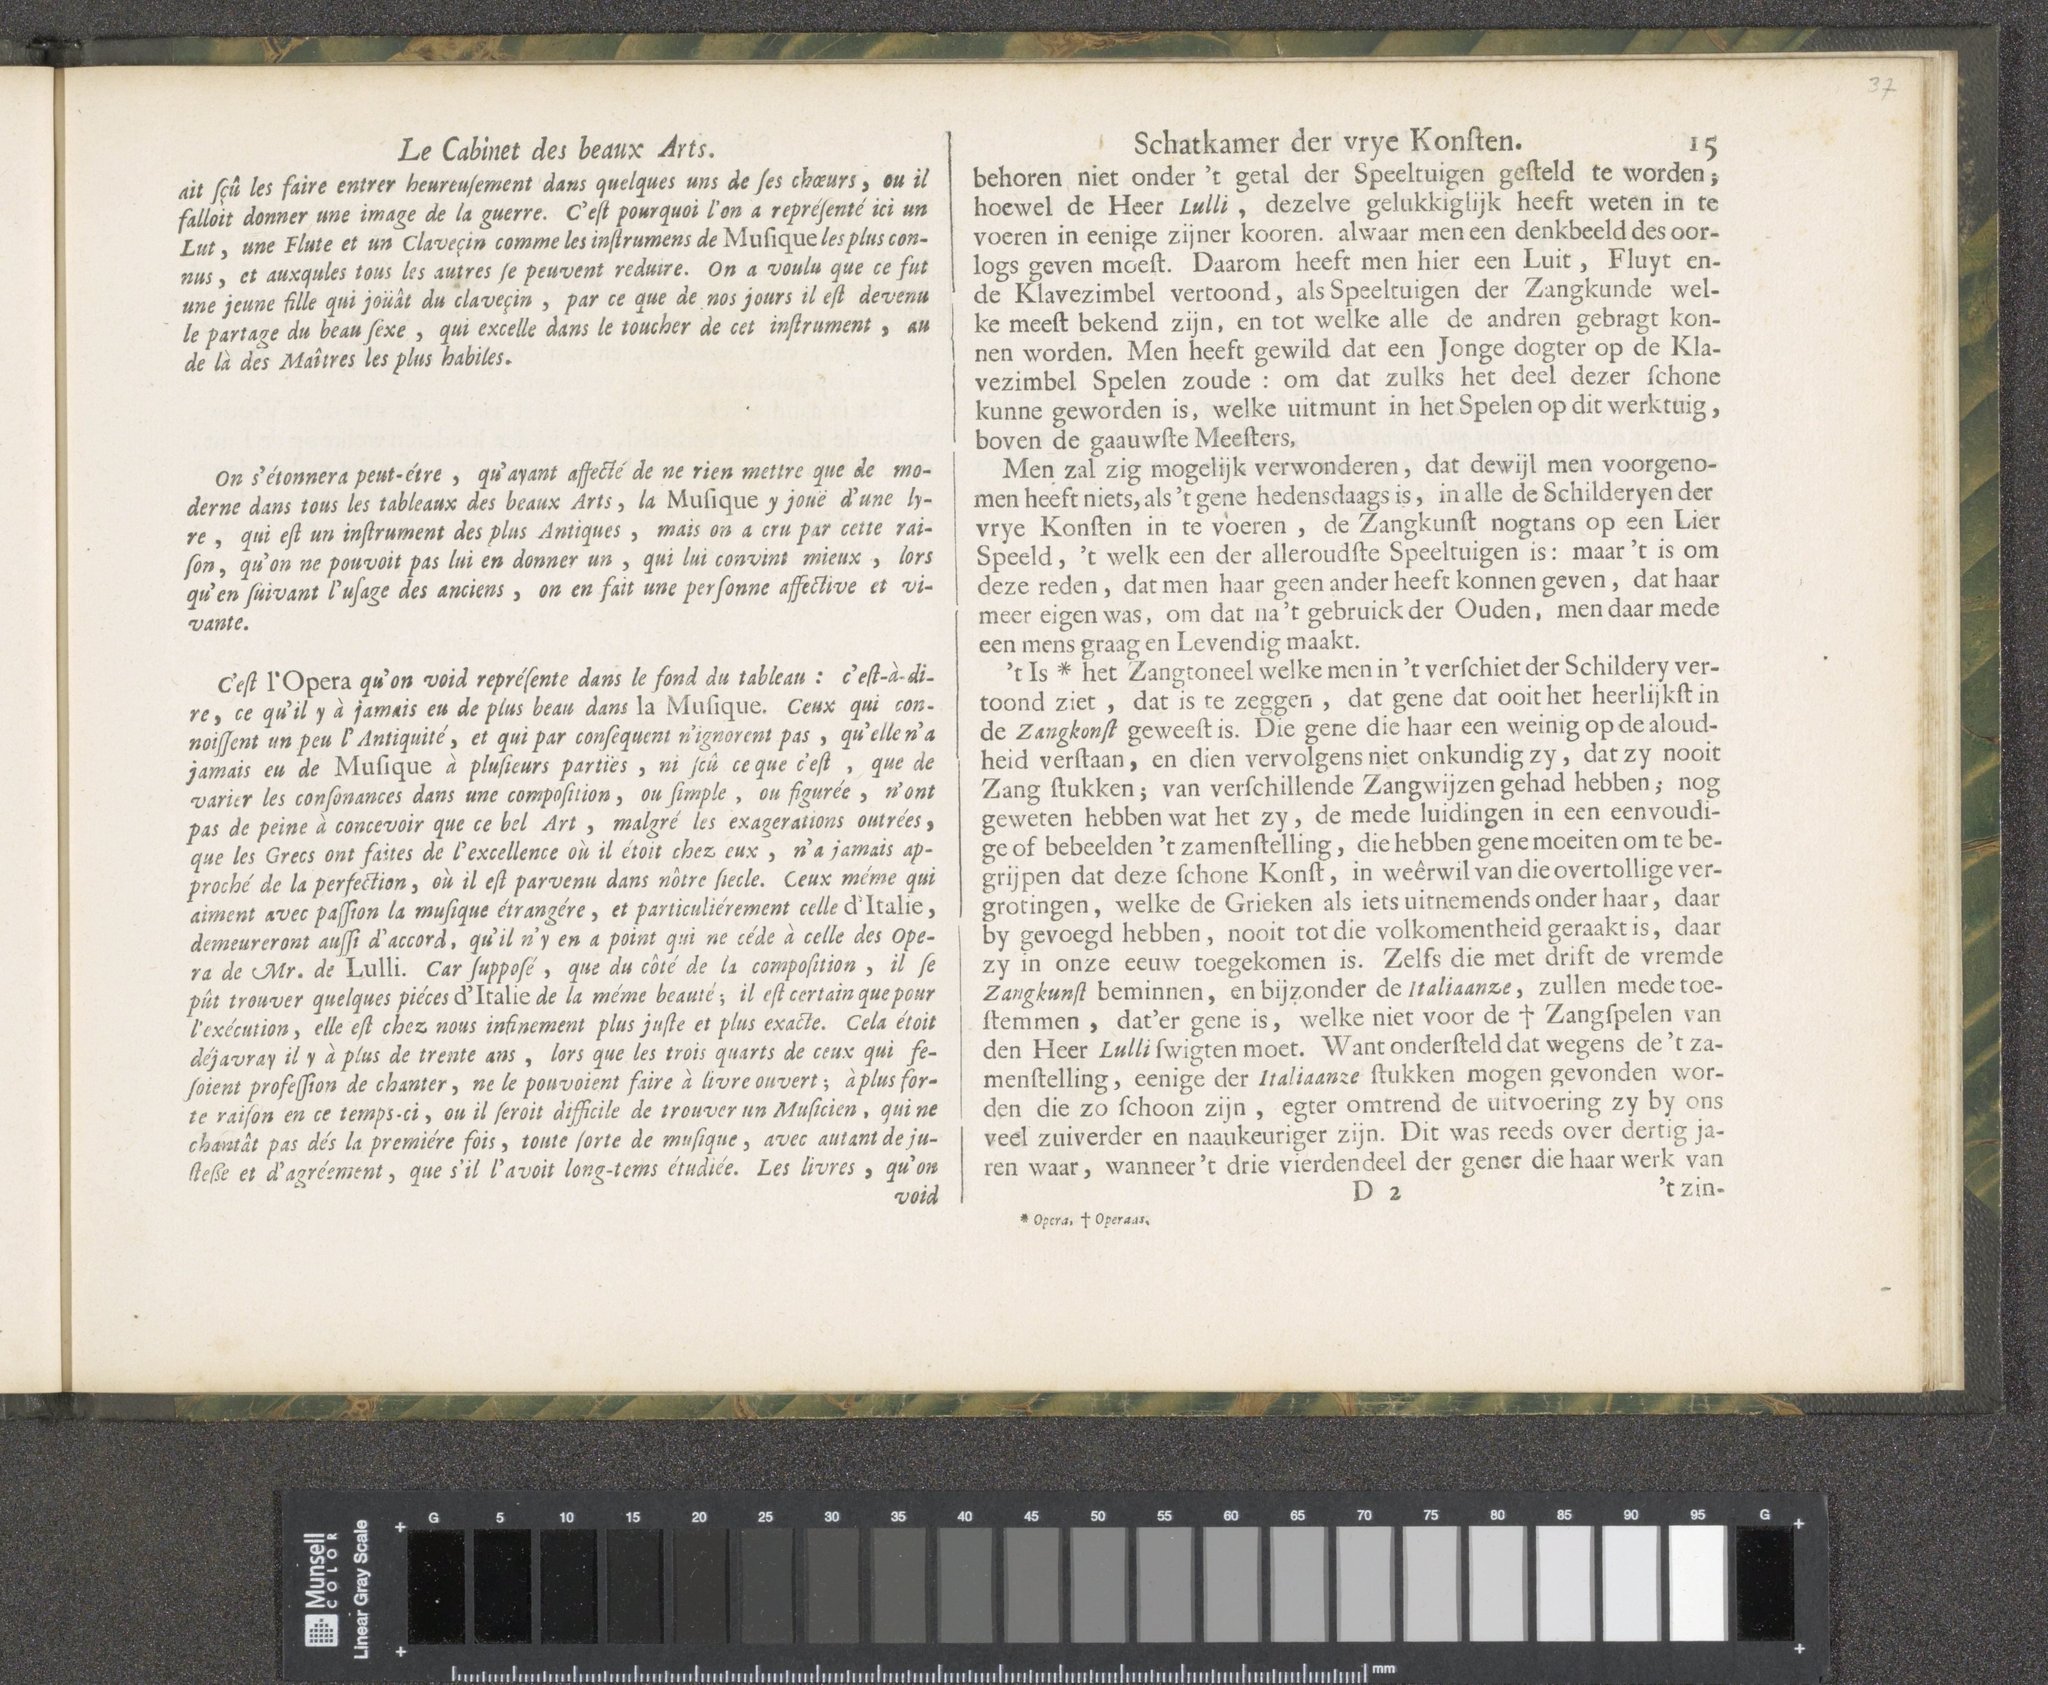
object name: text sheet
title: Tekstblad over de Muziek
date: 1693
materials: paper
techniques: letterpress printing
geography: amsterdam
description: Verklaring van de prent met de voorstelling van de personificatie van Muziek in het Frans en het Nederlands, pagina 15. Tekstblad maakt deel uit van een album.